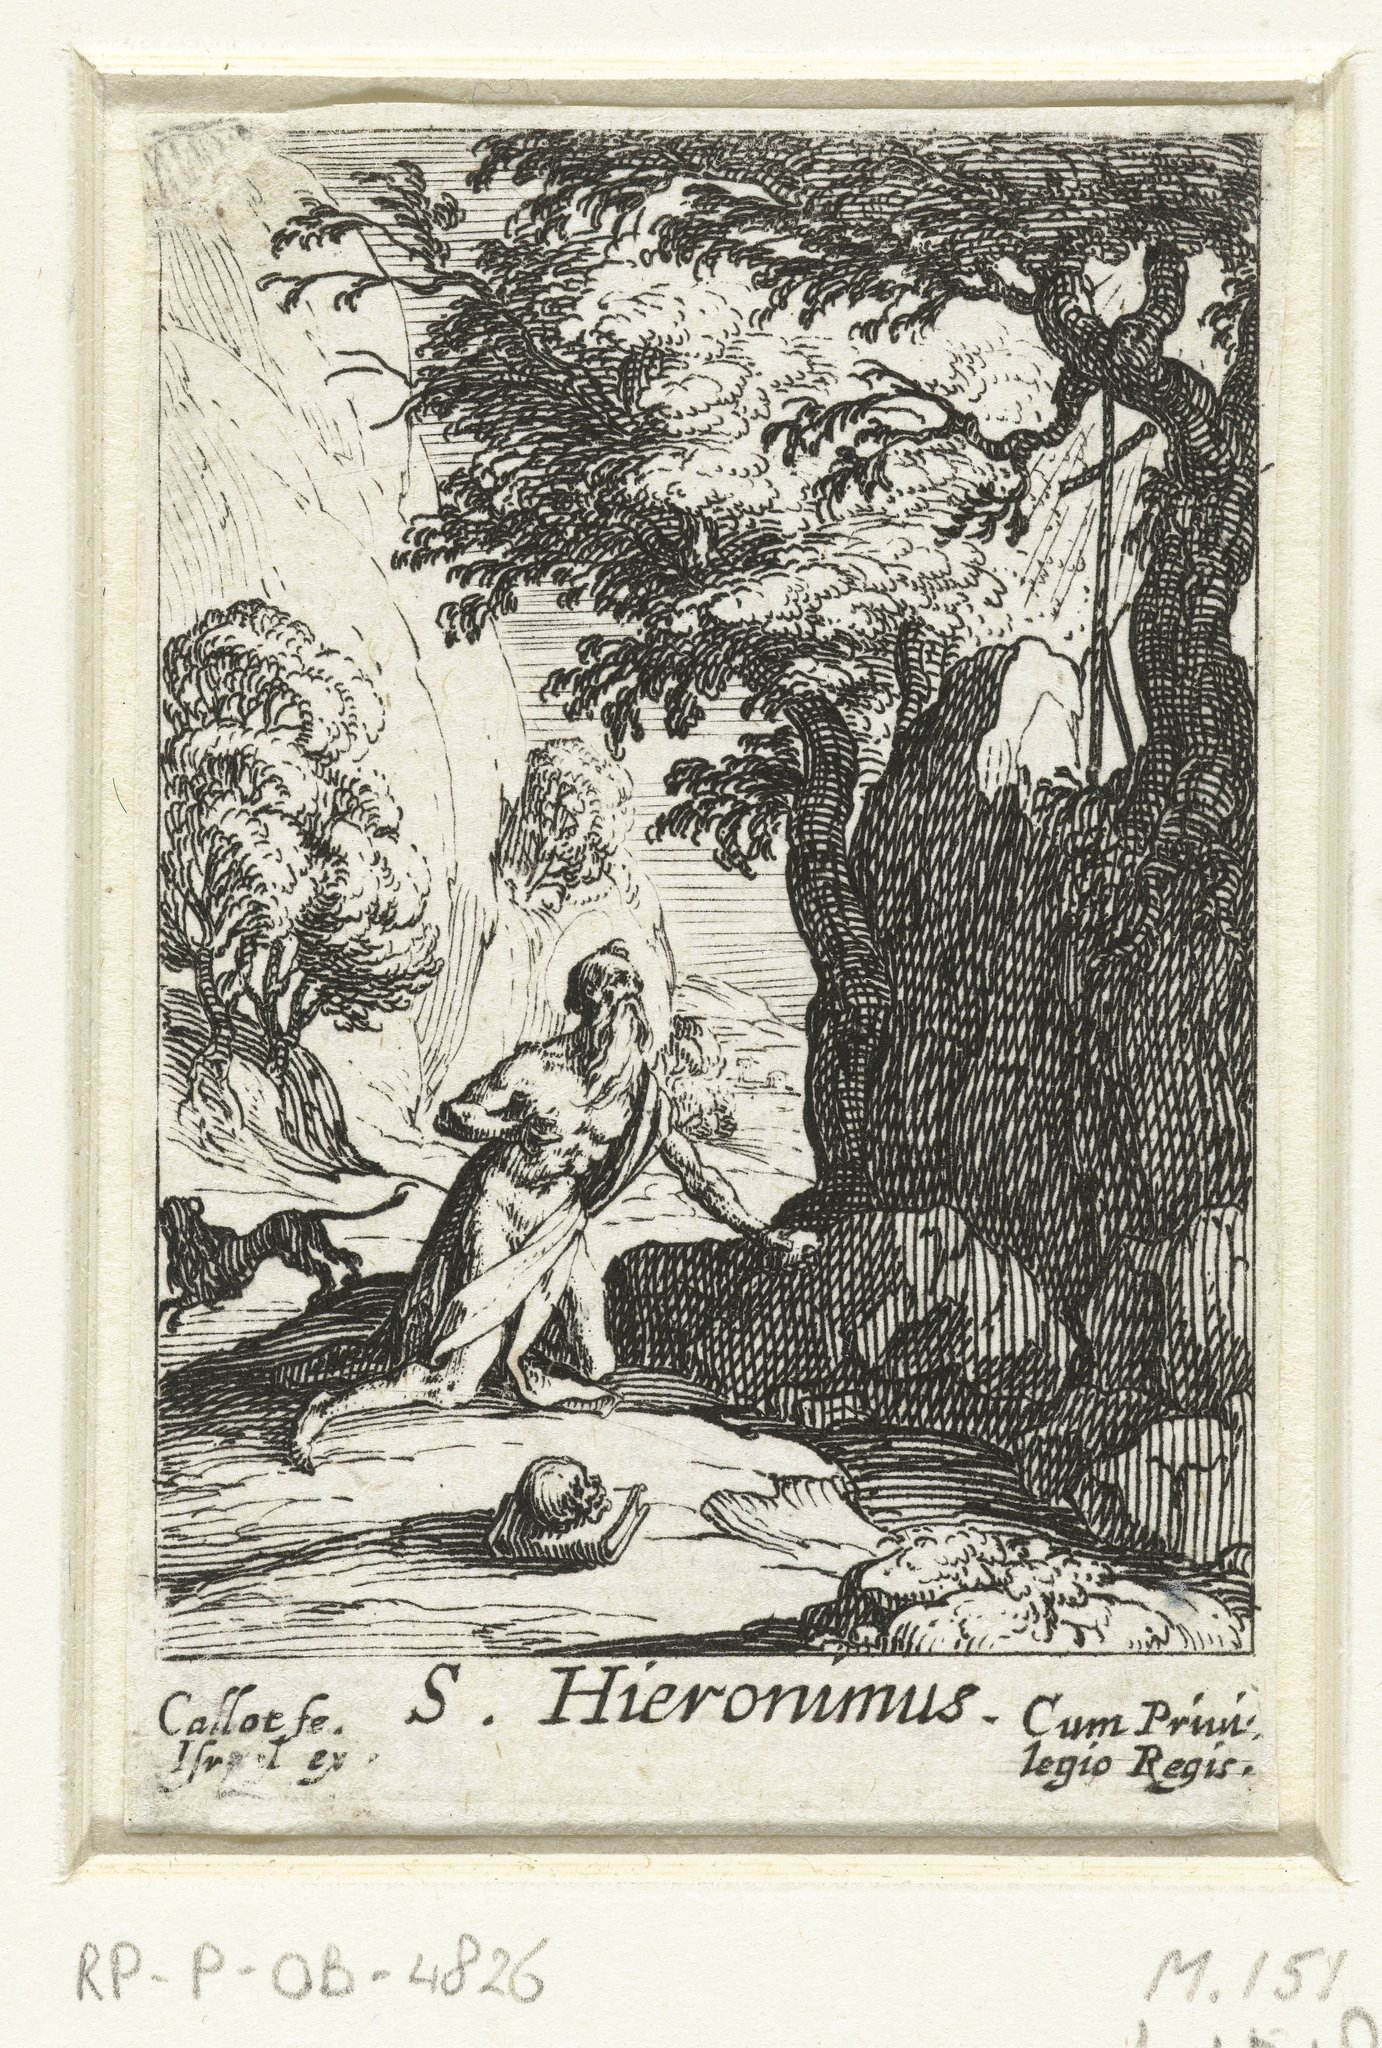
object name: print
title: S. Hieronimus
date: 1632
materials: paper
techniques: etching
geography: nancy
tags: st. jerome as penitent in the desert, half naked, kneeling before a crucifix and holding a stone in his hand to beat his breast; a skull (and other 'vanitas' symbols), sometimes a scorpion and a snake beside him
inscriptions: collector's mark: Lugt 240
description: In een rotsachtige omgeving zit Hiëronymus op zijn knieën bij een kruis met een steen in zijn hand. Achter hem springt een leeuw weg. Onder de voorstelling een onderschrift in Latijn. Deze prent is onderdeel van een serie van zes prenten, bestaande uit een titelprent en vijf voorstellingen van boetvaardige heiligen.